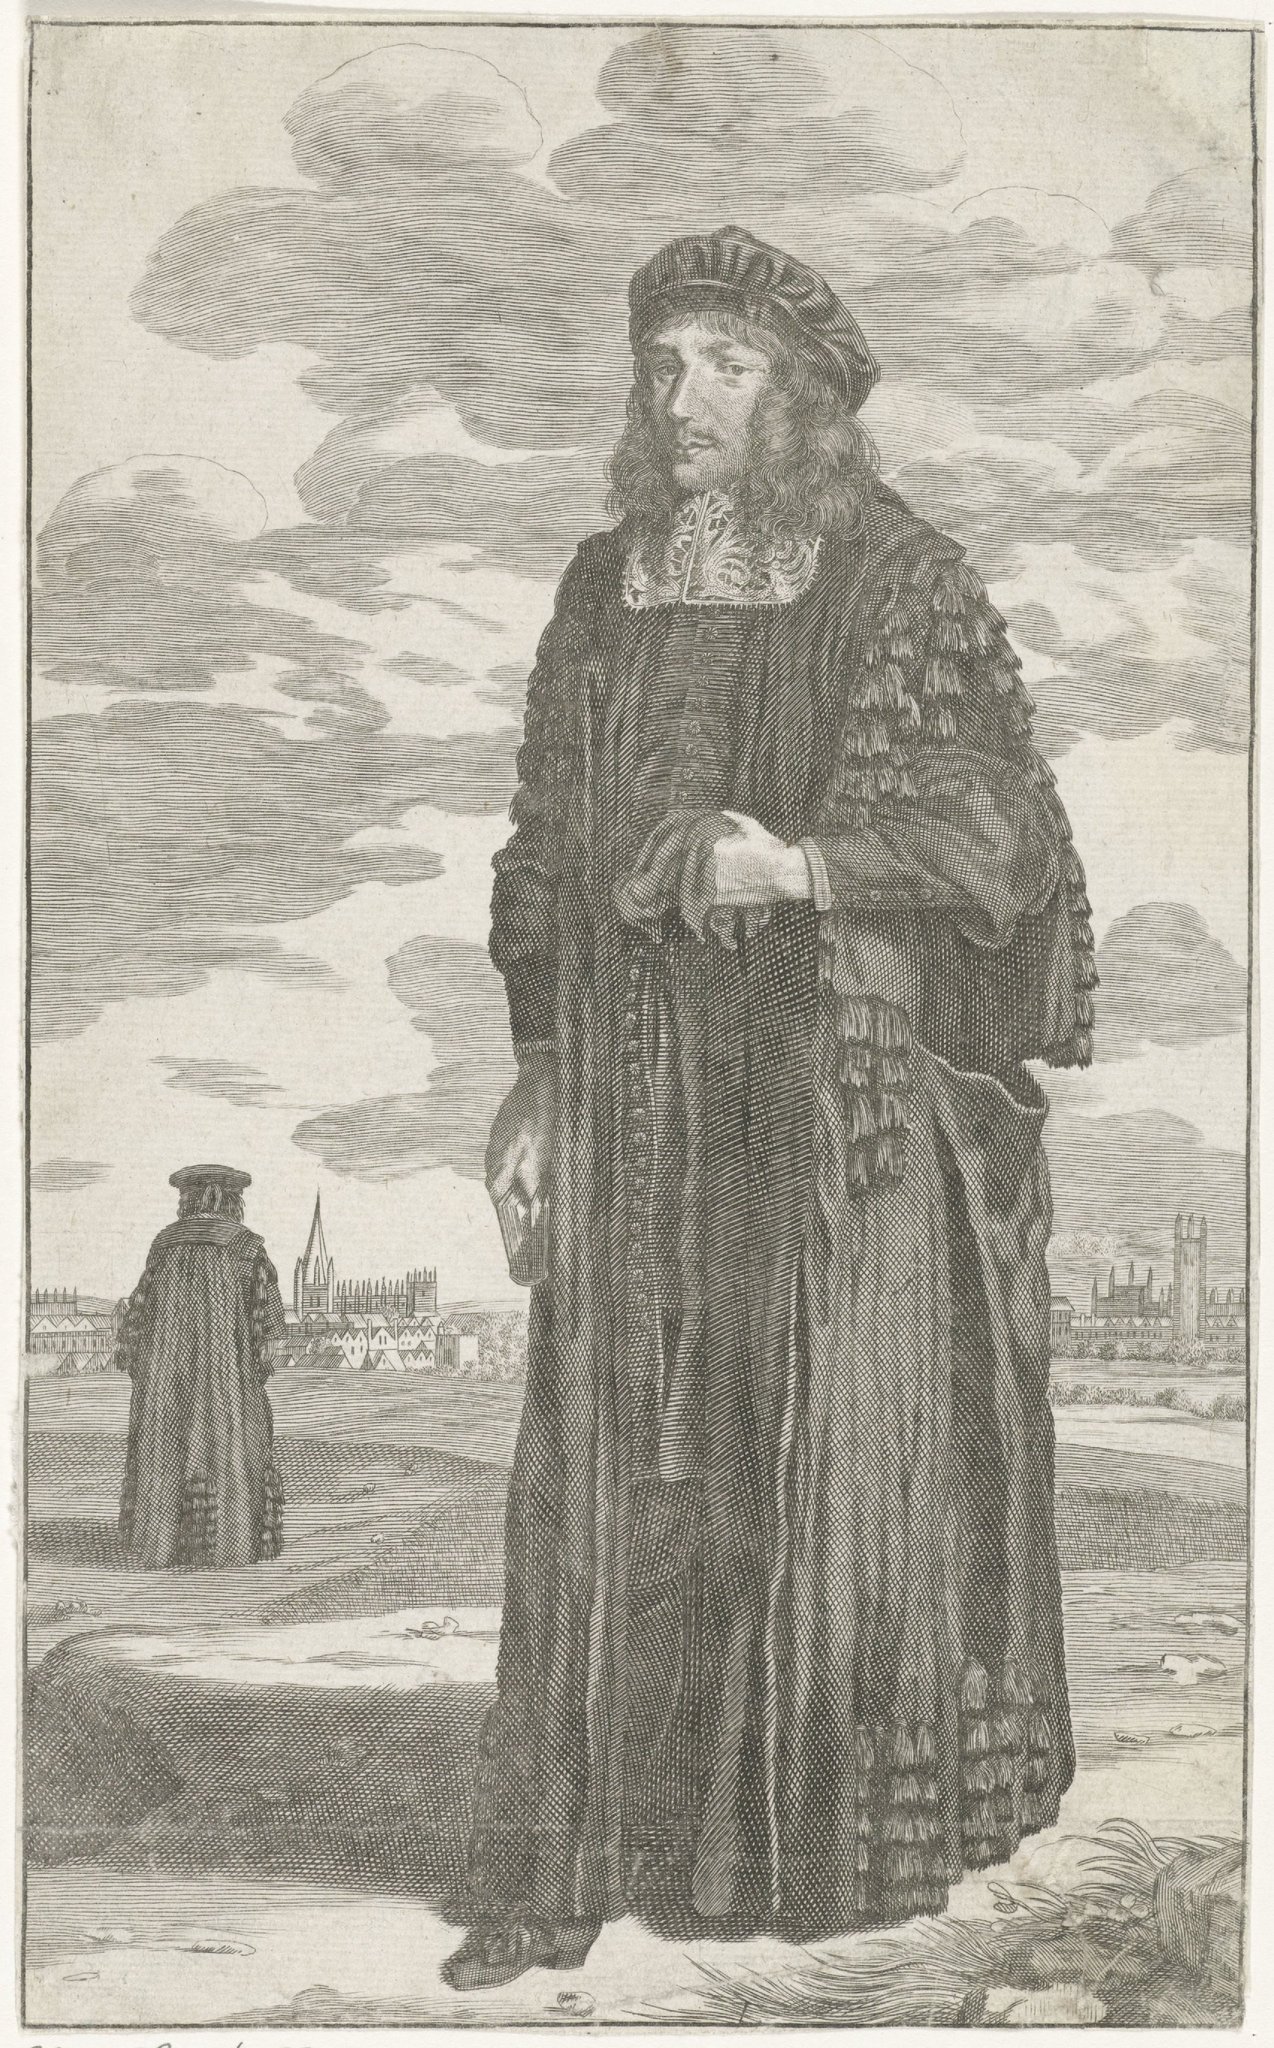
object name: print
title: Doctor in de geneeskunde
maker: david loggan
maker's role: print maker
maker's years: 1633-1692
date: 1643-1692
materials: paper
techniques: engraving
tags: physician, doctor (+ professional clothes of scholar, scientist), physician, doctor (+ scholar, scientist with pupils; lecture, discussion, learned academy)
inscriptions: collector's mark: Lugt 2228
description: Prent opgenomen in: Edwards, George. Reverendis et eruditis viris in theologia, medicina, et jure civili doctoribus, academiae Oxoniensis haec omnium ordinum habituum academicorum exemplaria quâ par est observantia. Oxford: s.n. 1674.